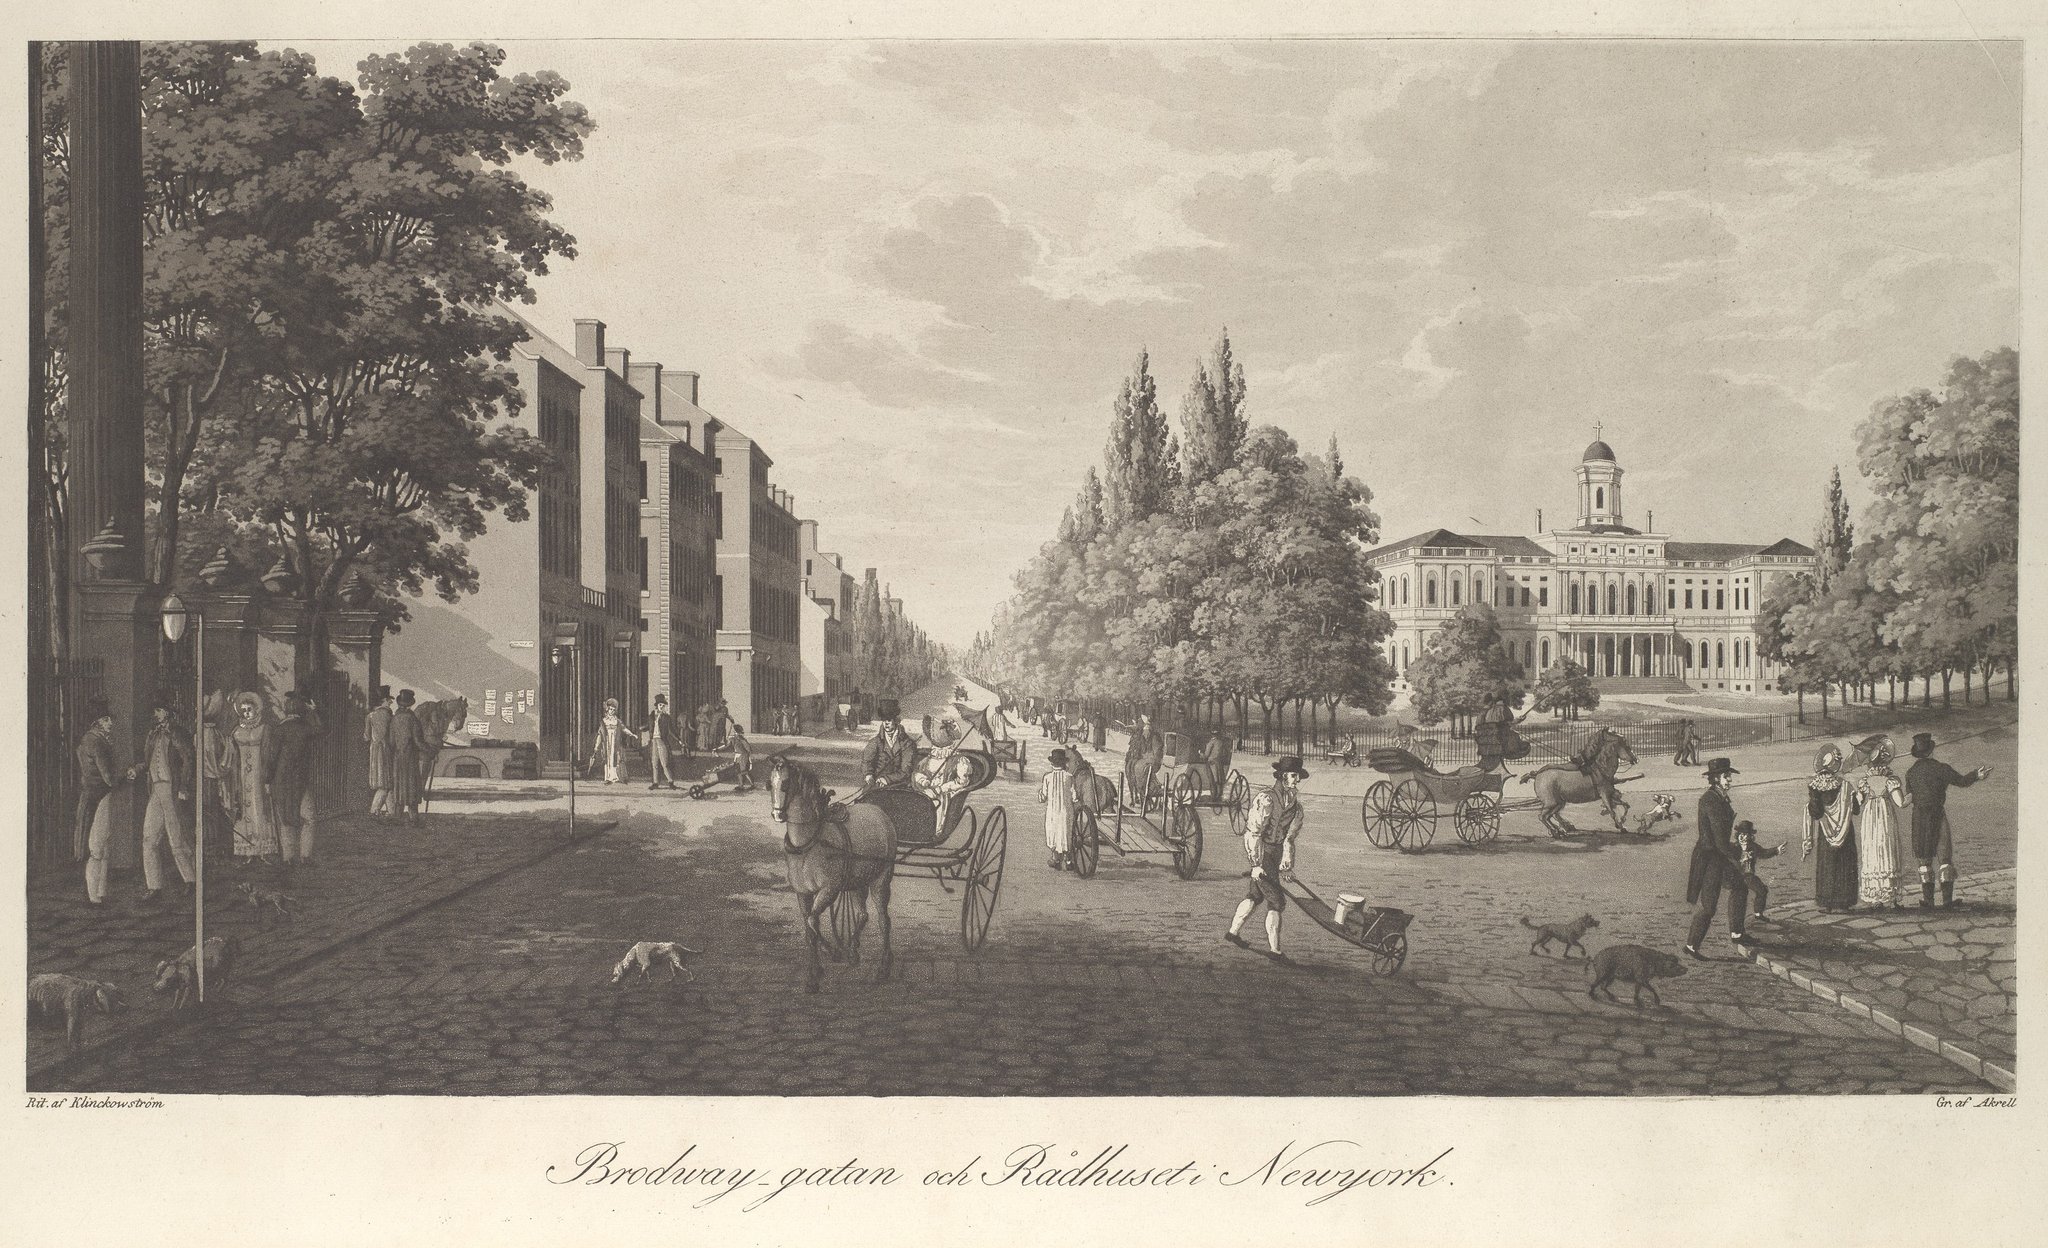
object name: print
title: Broadway and City Hall in New York (Brodway-Gatan Och Rådhuset i New York)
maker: carl fredrik akrell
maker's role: etcher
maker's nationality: swedish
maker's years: 1779-1868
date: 1824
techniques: aquatint, etching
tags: buildings,cities,streets,dogs,carriages,new york city